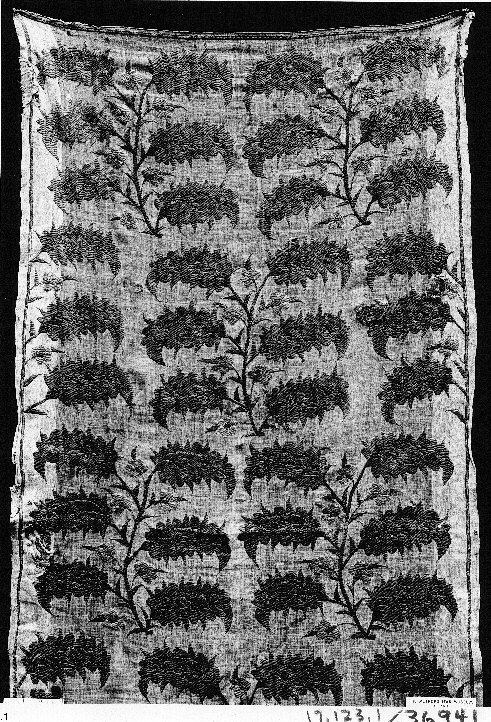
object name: cover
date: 1701-1800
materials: cotton, silk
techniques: embroidery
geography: turkey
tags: leaves